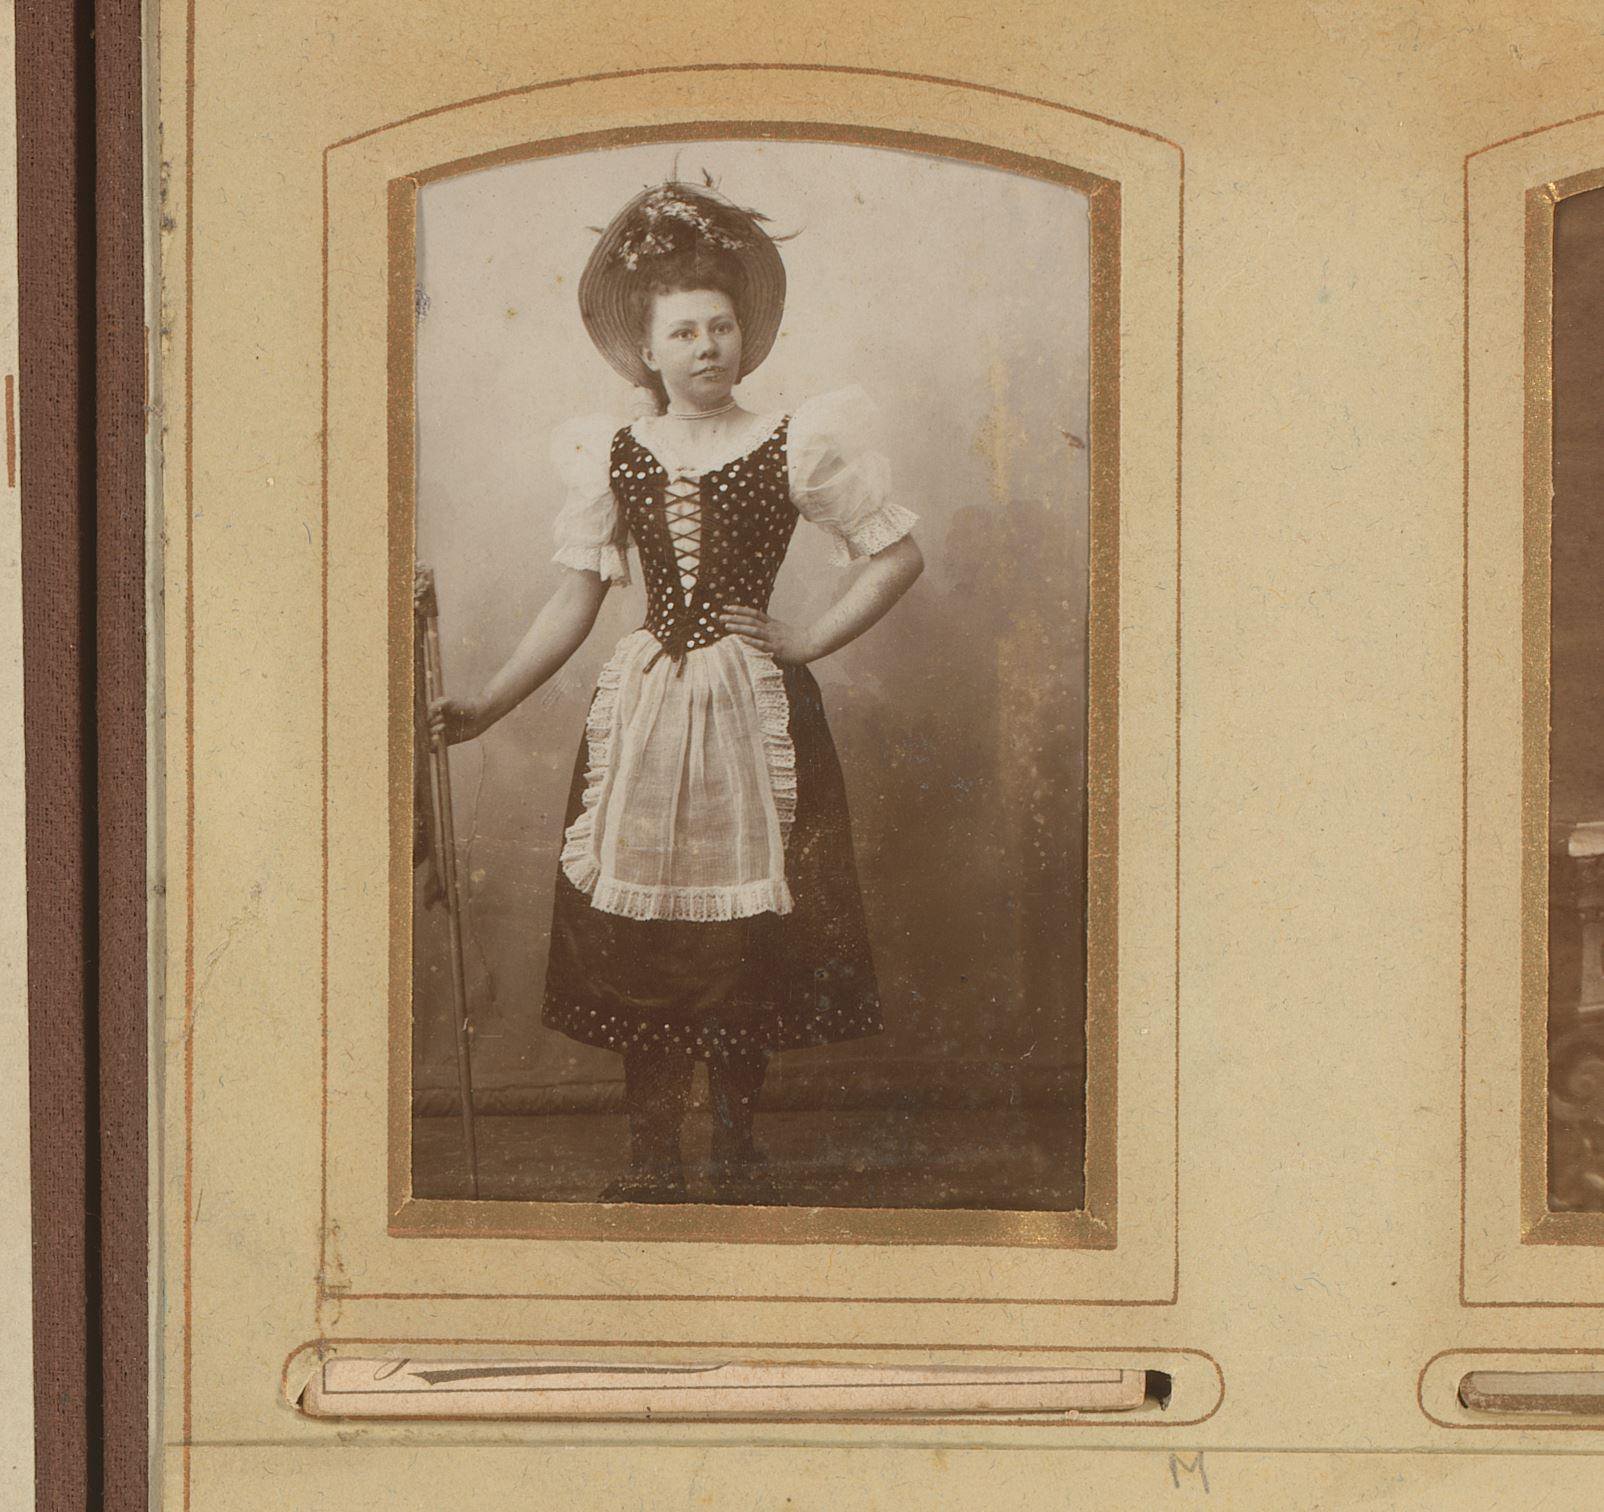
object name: photograph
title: Portret van een staand meisje, verkleed als herderin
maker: cornelis johannes lodewicus vermeulen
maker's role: fotograaf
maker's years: 1861-1936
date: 1888-1896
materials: cardboard, photographic support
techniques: collodion silver print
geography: amsterdam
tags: historical persons - bb - woman, herding, herdsman, herdswoman, shepherd, shepherdess, cowherd, etc., girl (child between toddler and youth)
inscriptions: inscription: ‘Photographische/ Ateliers/ C.J.L. Vermeulen/ Heerenstraat 6,/ &/ Heiligenweg/ hoek Singel/ Amsterdam./ Specialiteit in vergrootingen.’